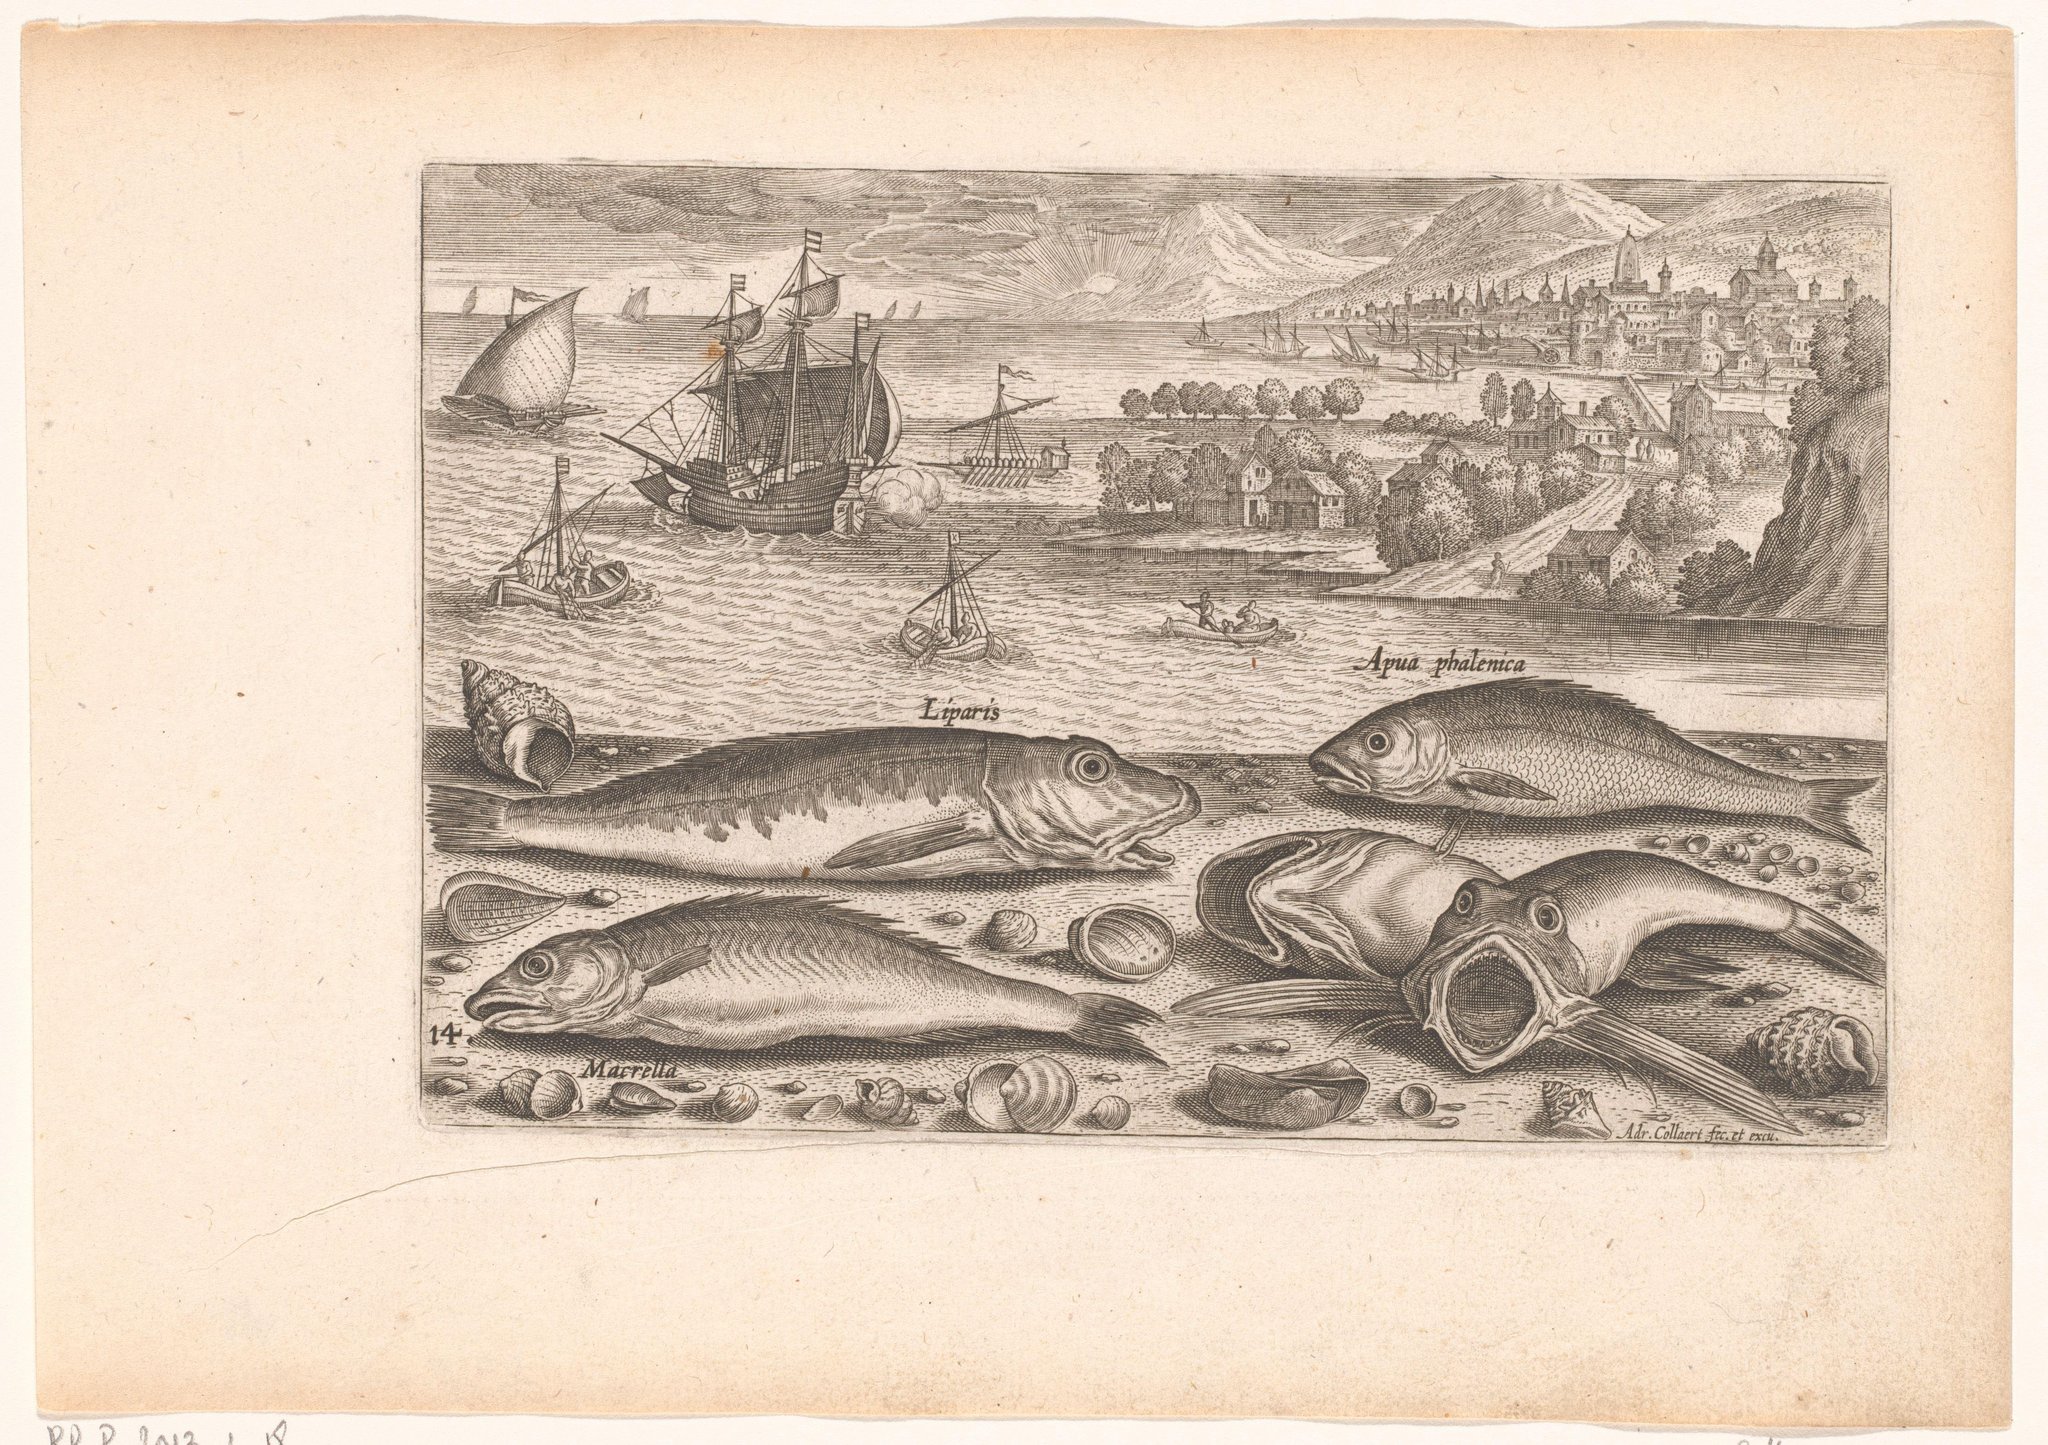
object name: print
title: Vijf vissen op het strand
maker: adriaen collaert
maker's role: draughtsman, print maker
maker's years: 1560-1618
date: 1595-1618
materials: paper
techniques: engraving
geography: antwerp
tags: sea (seascape), bony fishes: mackerel, bony fishes: gurnard, bony fishes: bream, bony fishes: snail-fish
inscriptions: number: ‘54/17’, collector's mark: Lugt 2228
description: Een brasem, een makreel, twee ponen en een snotolf liggen samen met wat schelpen aangespoeld op het strand. Op de achtergrond de zee met enkele schepen. De prent maakt deel uit van een serie met vissen als onderwerp.